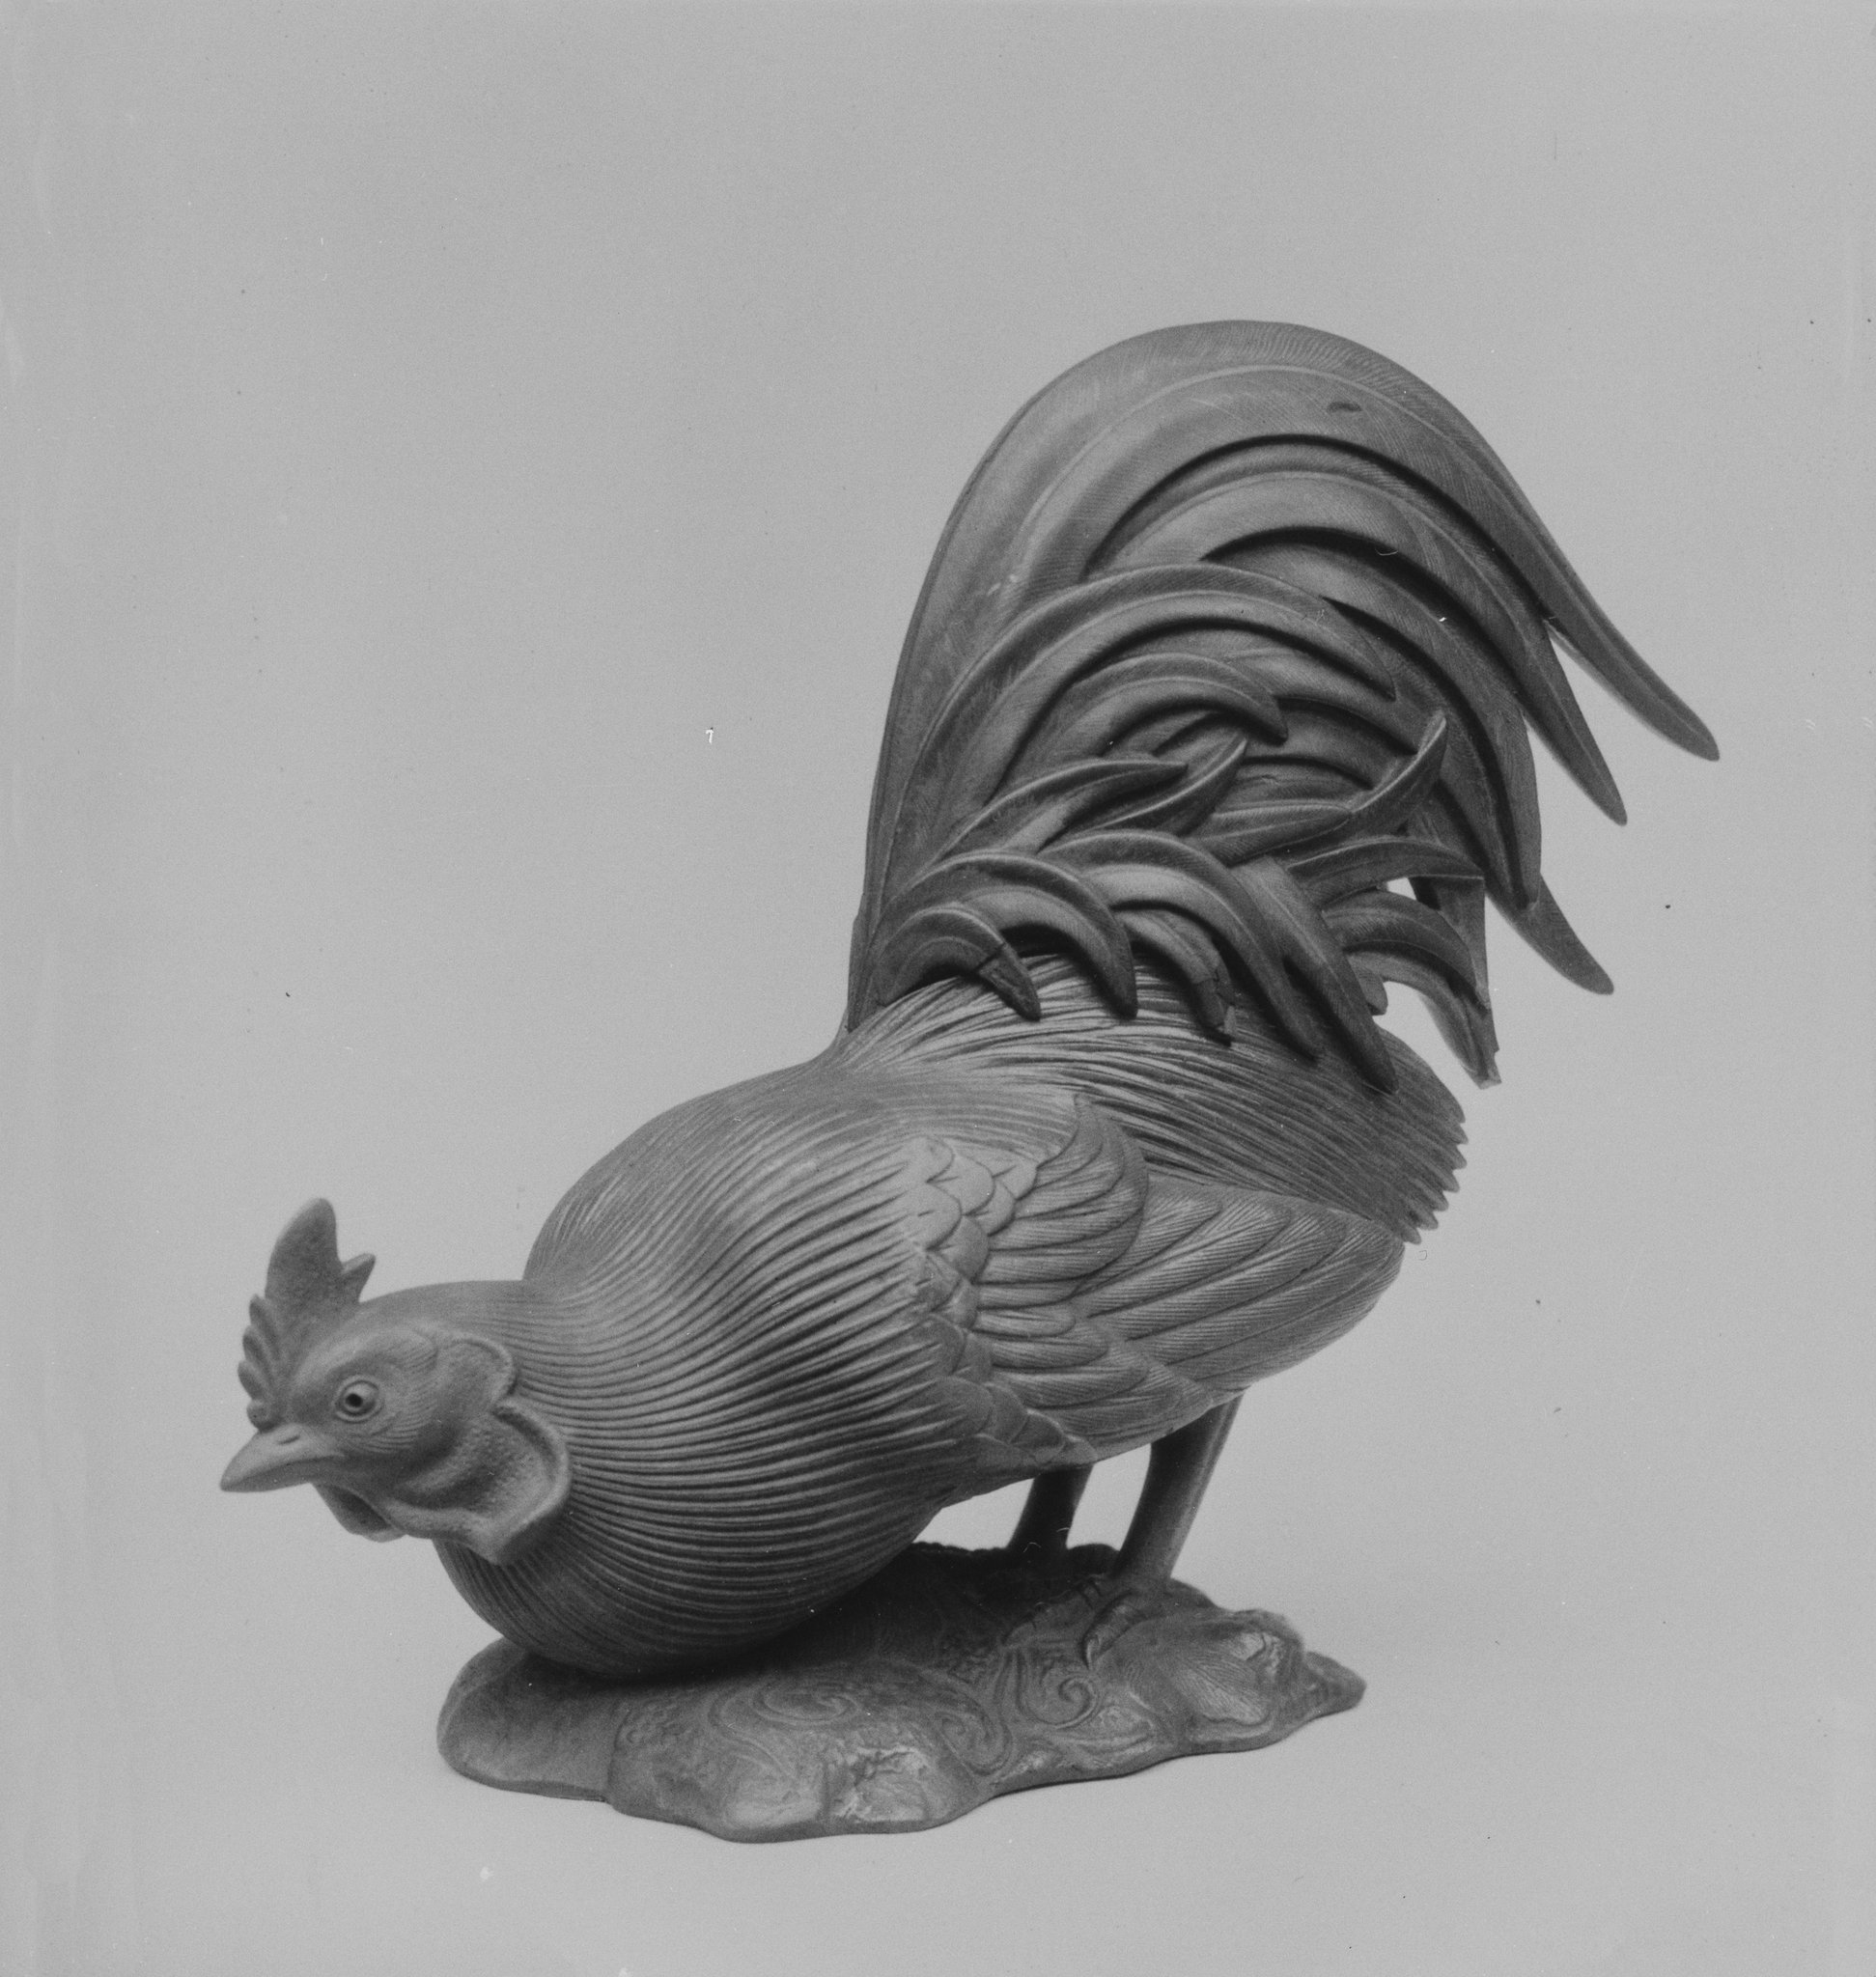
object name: censer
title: Censer in Form of a Cock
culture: japanese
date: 1650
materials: glaze, stoneware, wood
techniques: lacquer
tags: roosters,censers